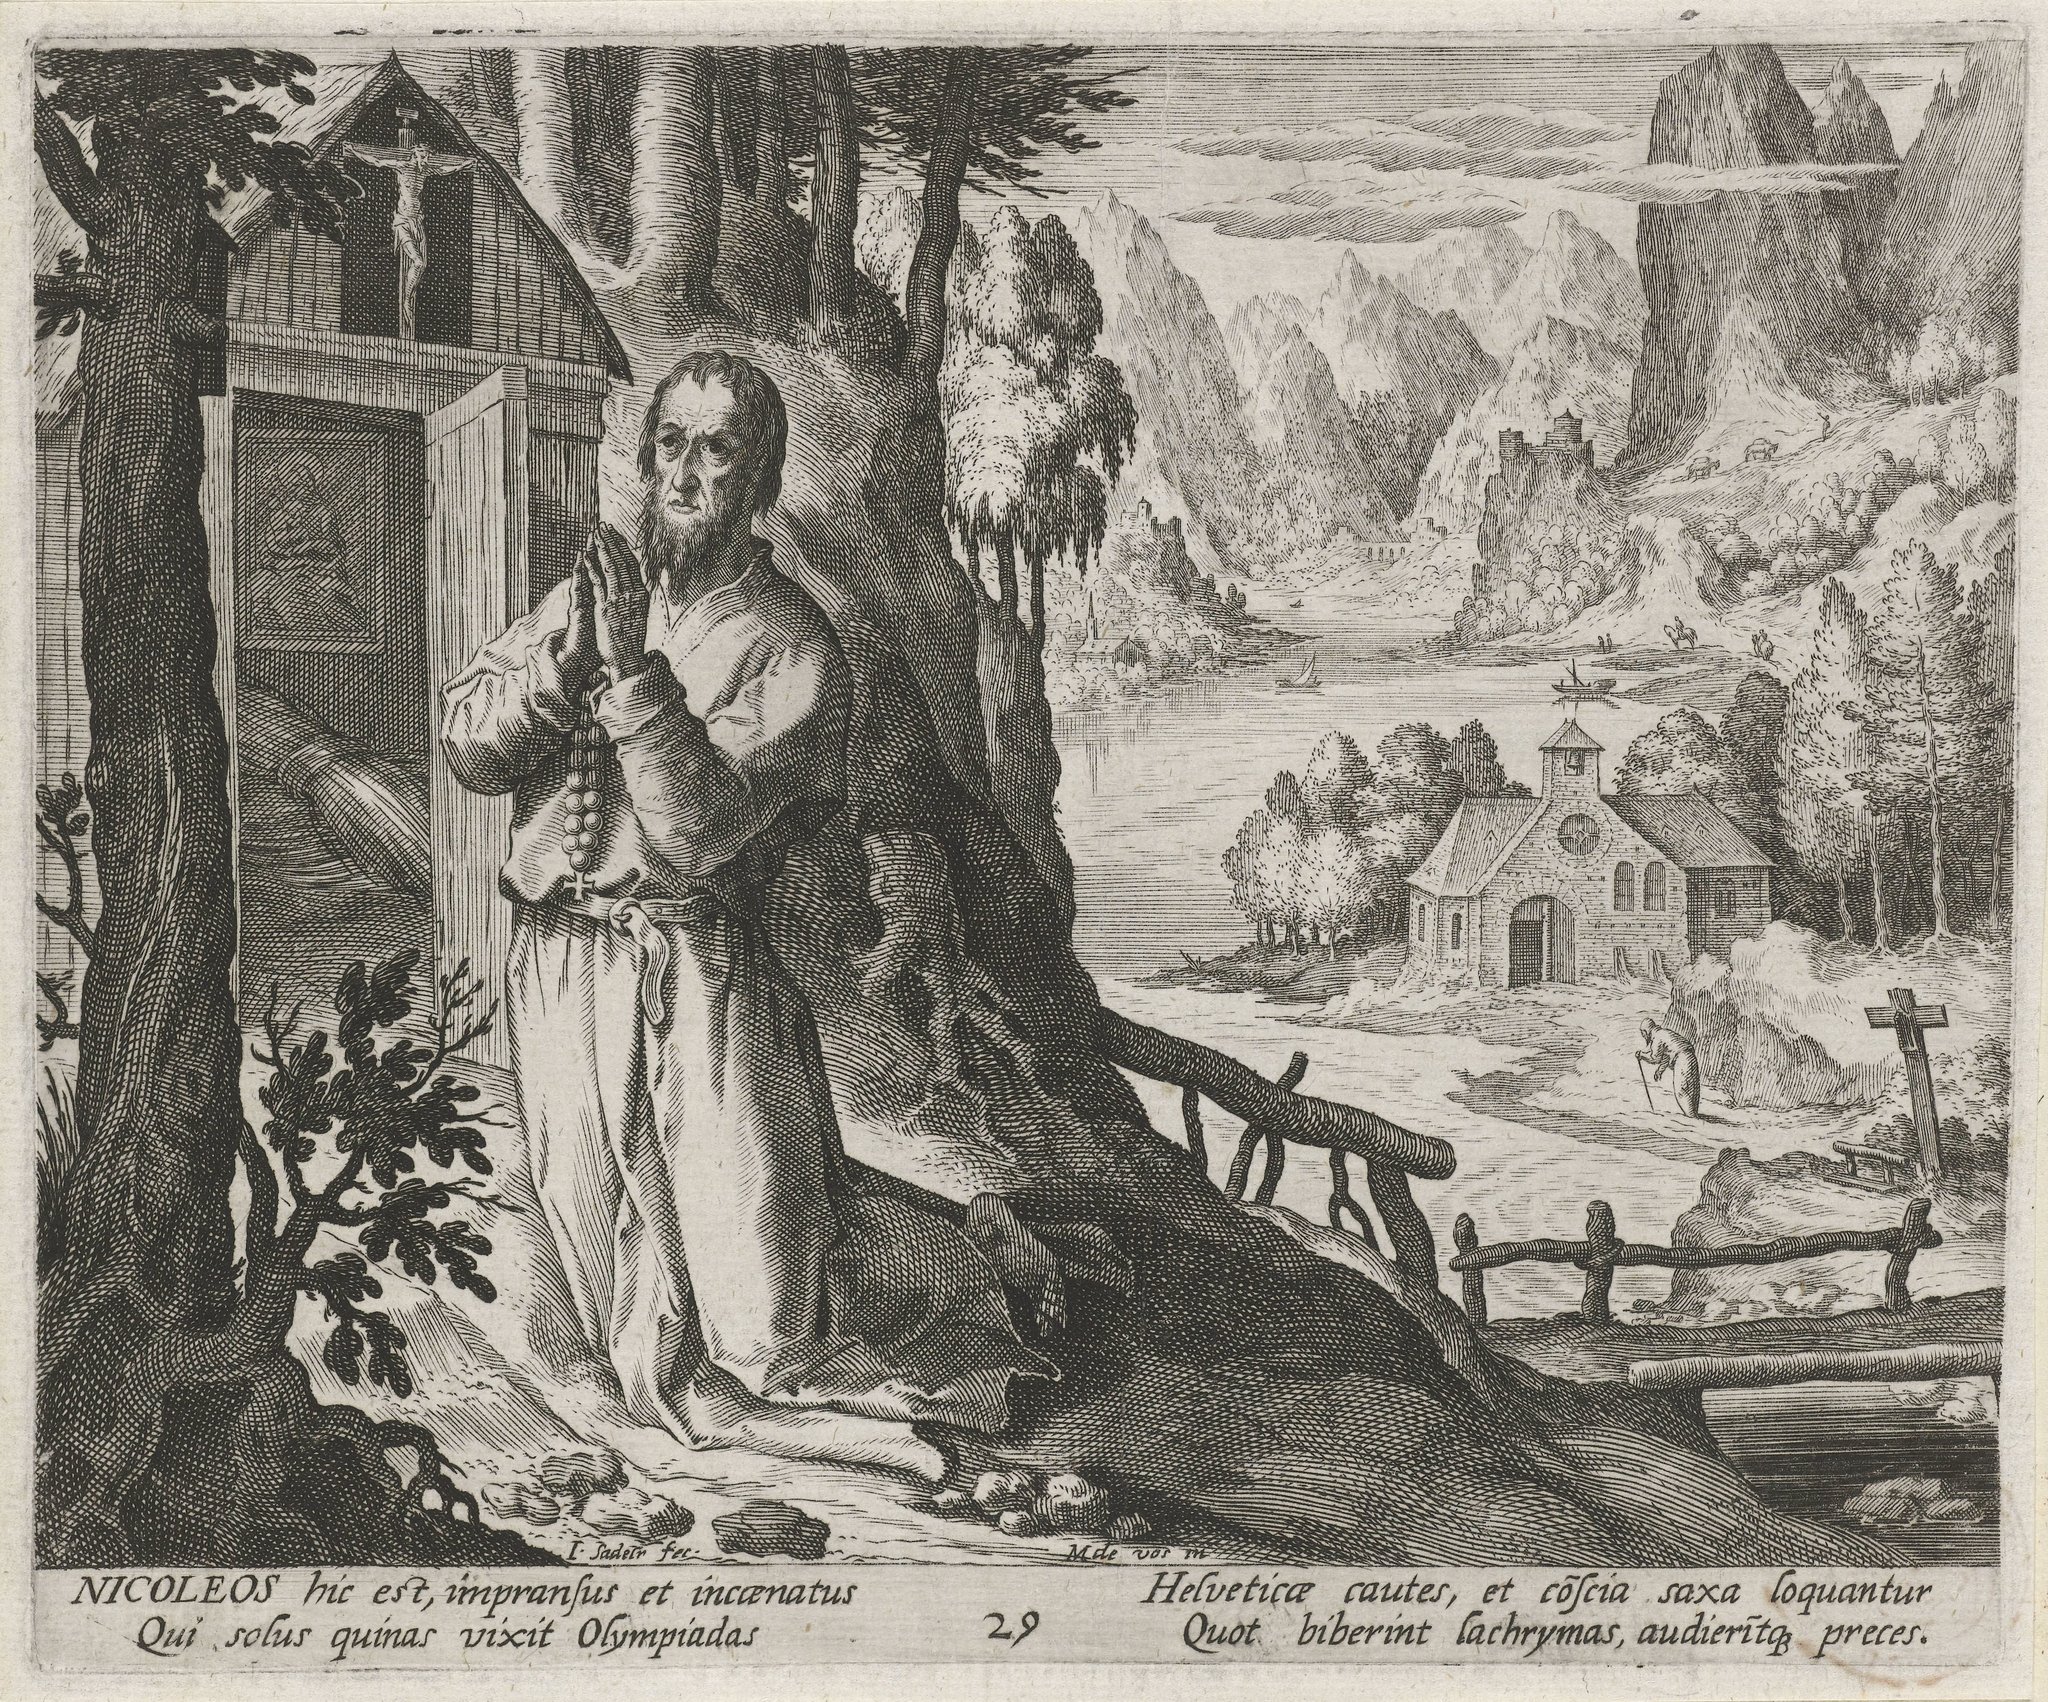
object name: print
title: Sylvae Sacrae Monumenta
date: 1594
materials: paper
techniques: engraving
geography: munich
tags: male saints (with name), anchorite, hermit, church (exterior) - qq - small church, chapel, mountains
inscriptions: collector's mark: Lugt 240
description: De H. Nicolaas van Flüe, een Zwitserse kluizenaar uit de vijftiende eeuw na Christus. Hij zit geknield de rozenkrans te bidden voor een kapel. Op de achtergrond een berglandschap en een kerkje.